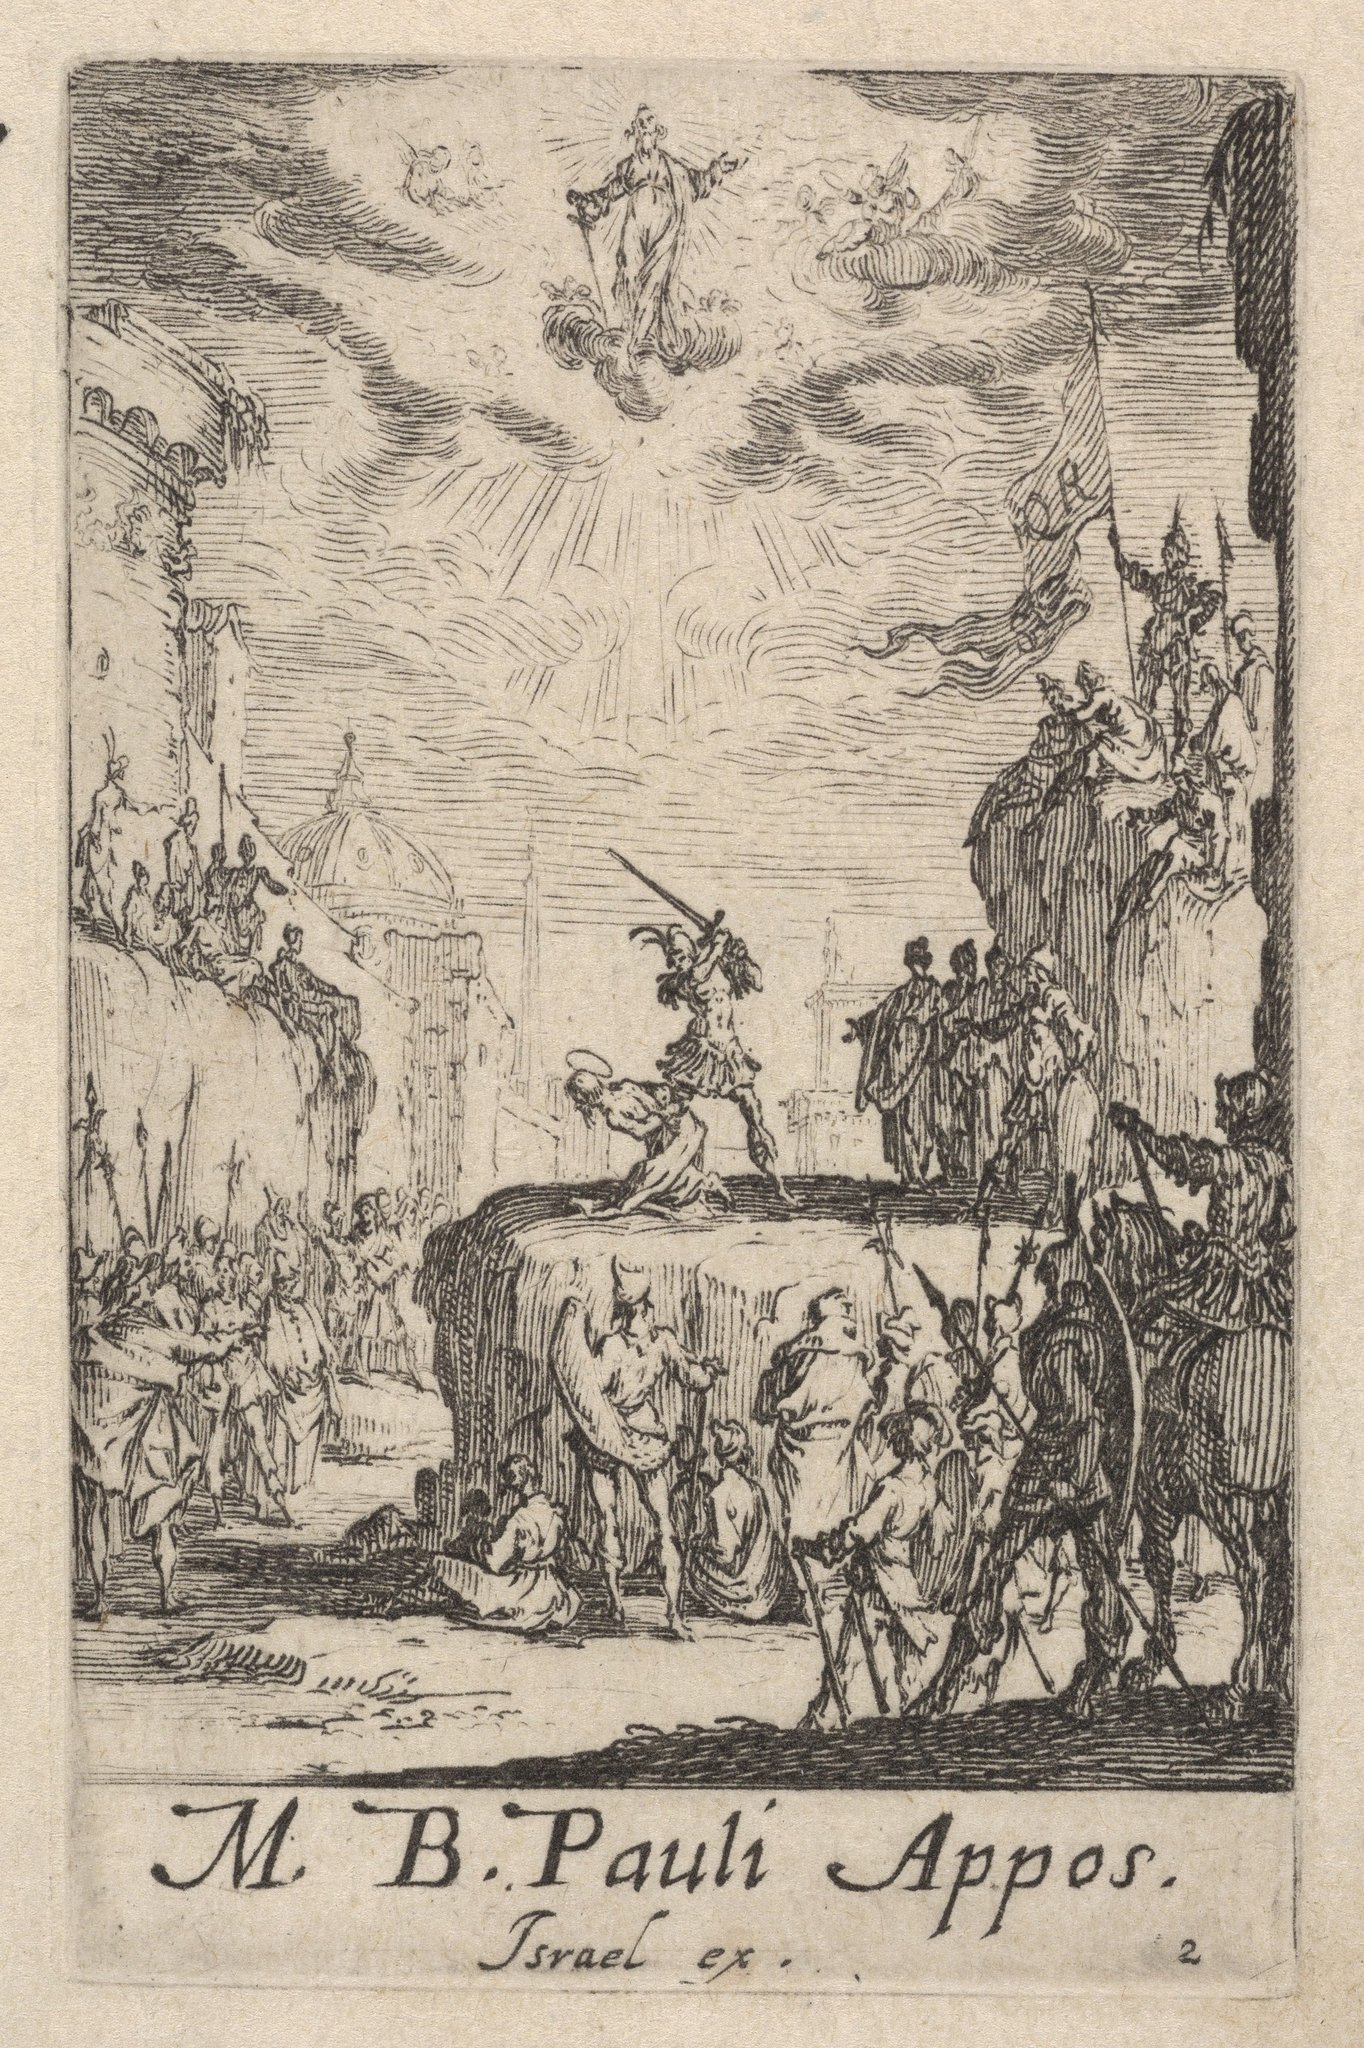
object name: print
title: Martyrdom of Saint Paul, from "The Little Apostles" (Les Petits Apôtres)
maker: jacques callot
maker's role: artist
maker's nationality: french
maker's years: 1592-1635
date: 1632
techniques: etching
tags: saint paul